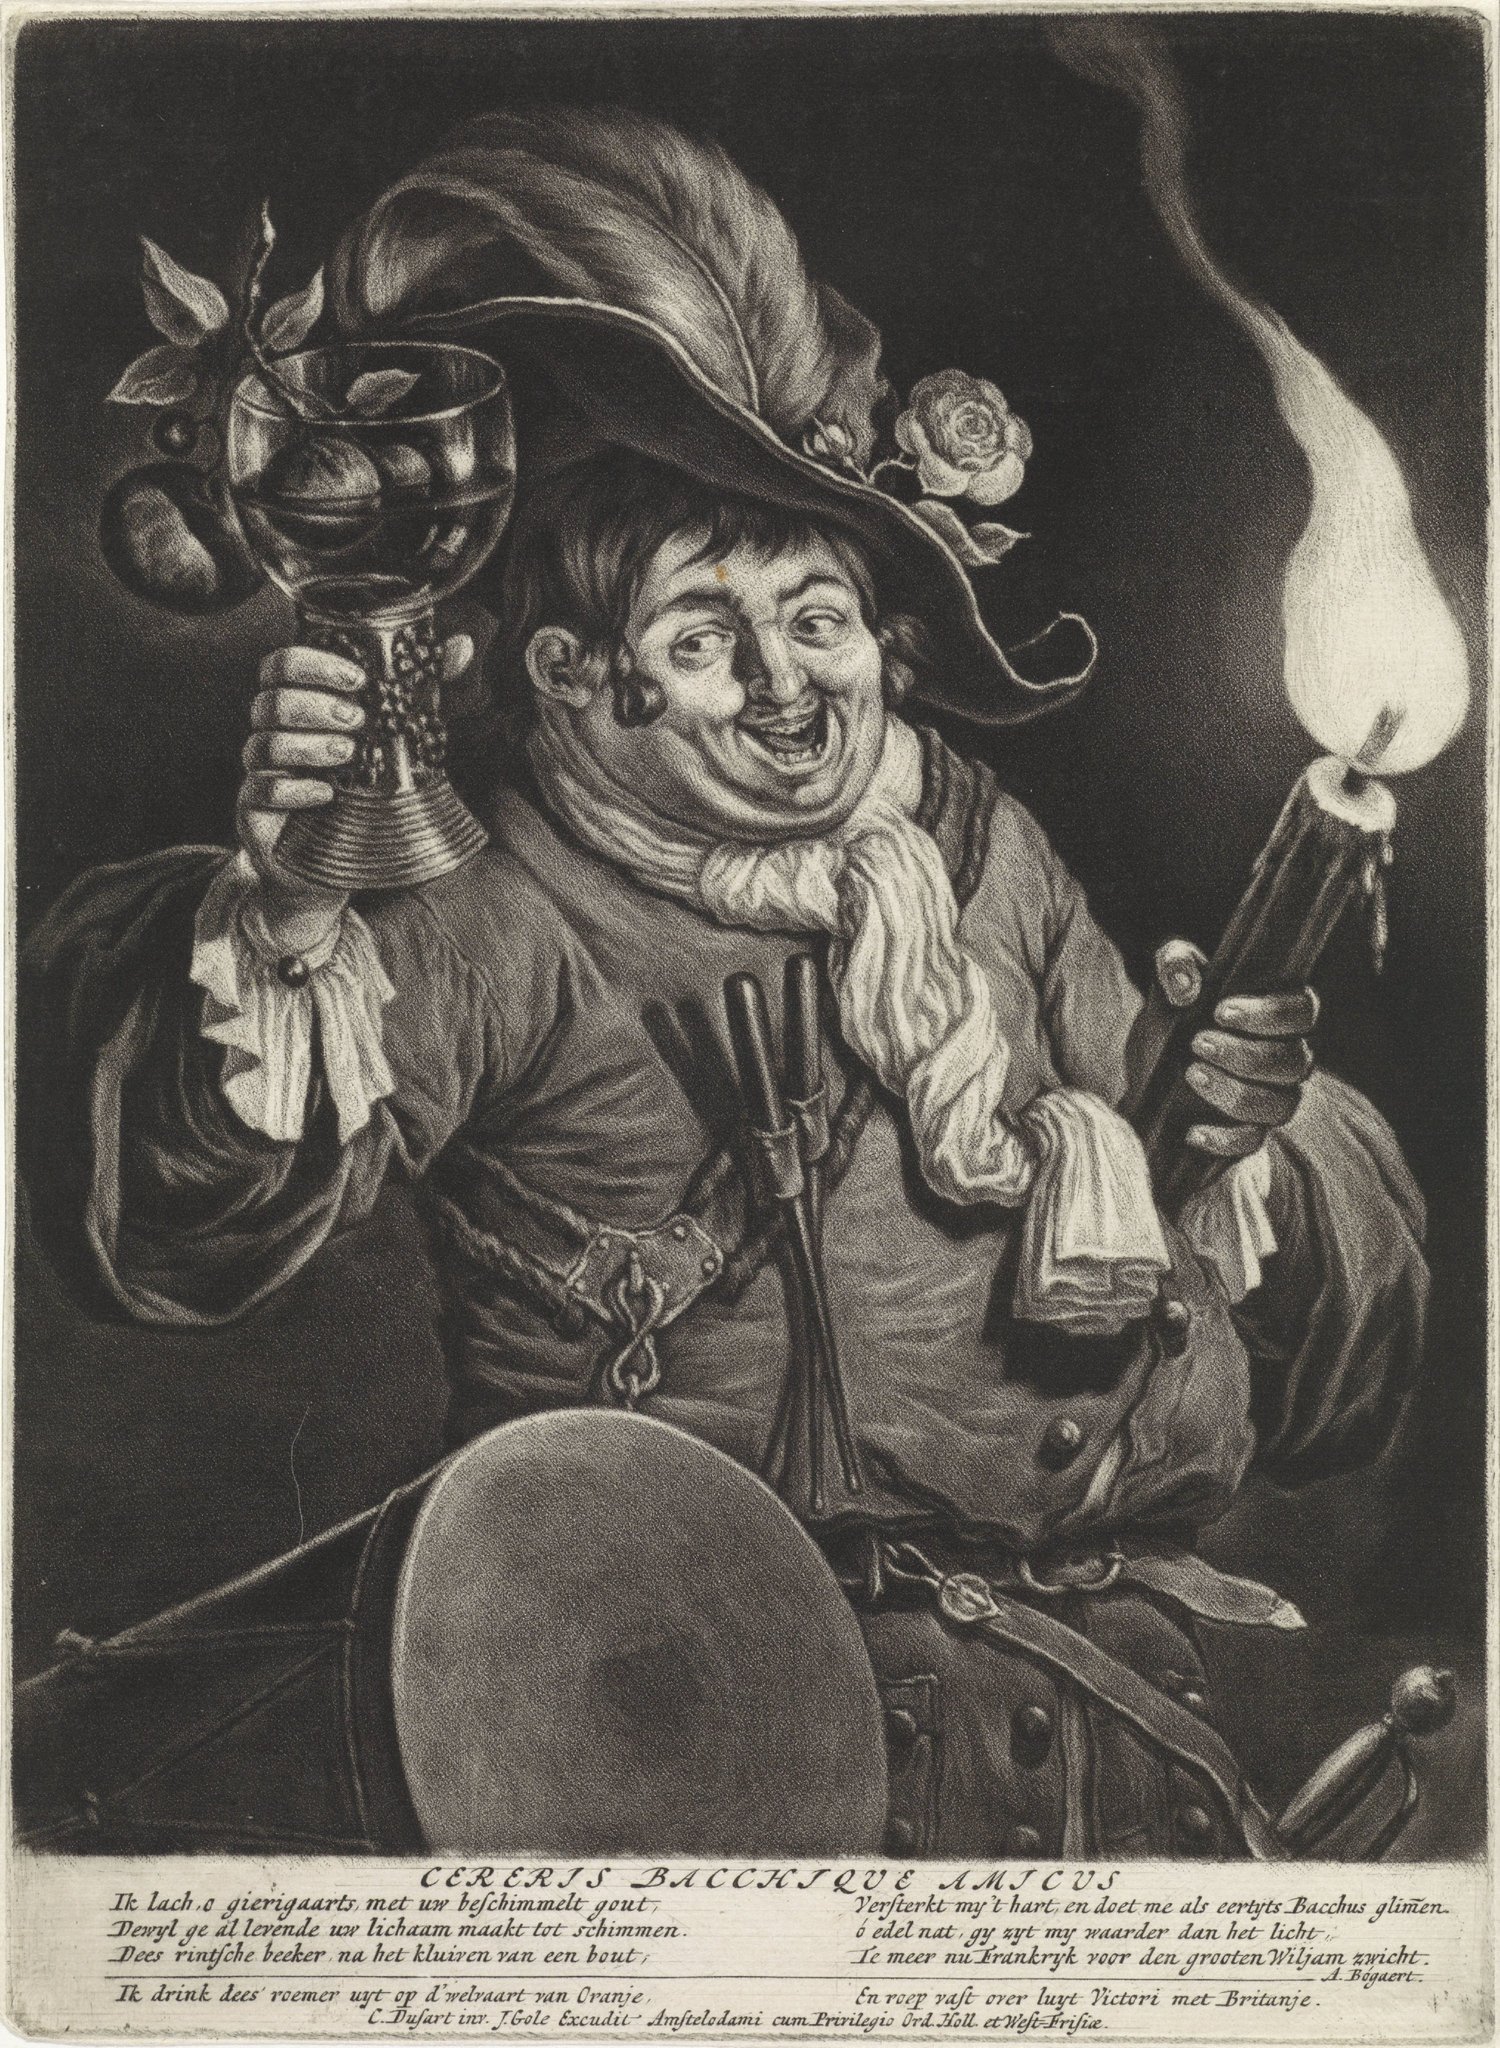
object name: print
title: De algemene blijdschap om de inname van Namen door stadhouder Willem III, koning van Engeland, september 1695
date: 1695-1724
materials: paper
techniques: engraving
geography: amsterdam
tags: torch, glass, rummer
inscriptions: collector's mark: Lugt 240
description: Lachende tamboer met roemer met een oranjetak en een brandende toorts. Onder de voorstelling een zesregelig vers waarin de verovering van Willem III op Frankrijk wordt bejubeld. De prent maakt deel uit van de reeks van acht prenten vervaardigd naar aanleiding van de verovering van Namen in 1695.